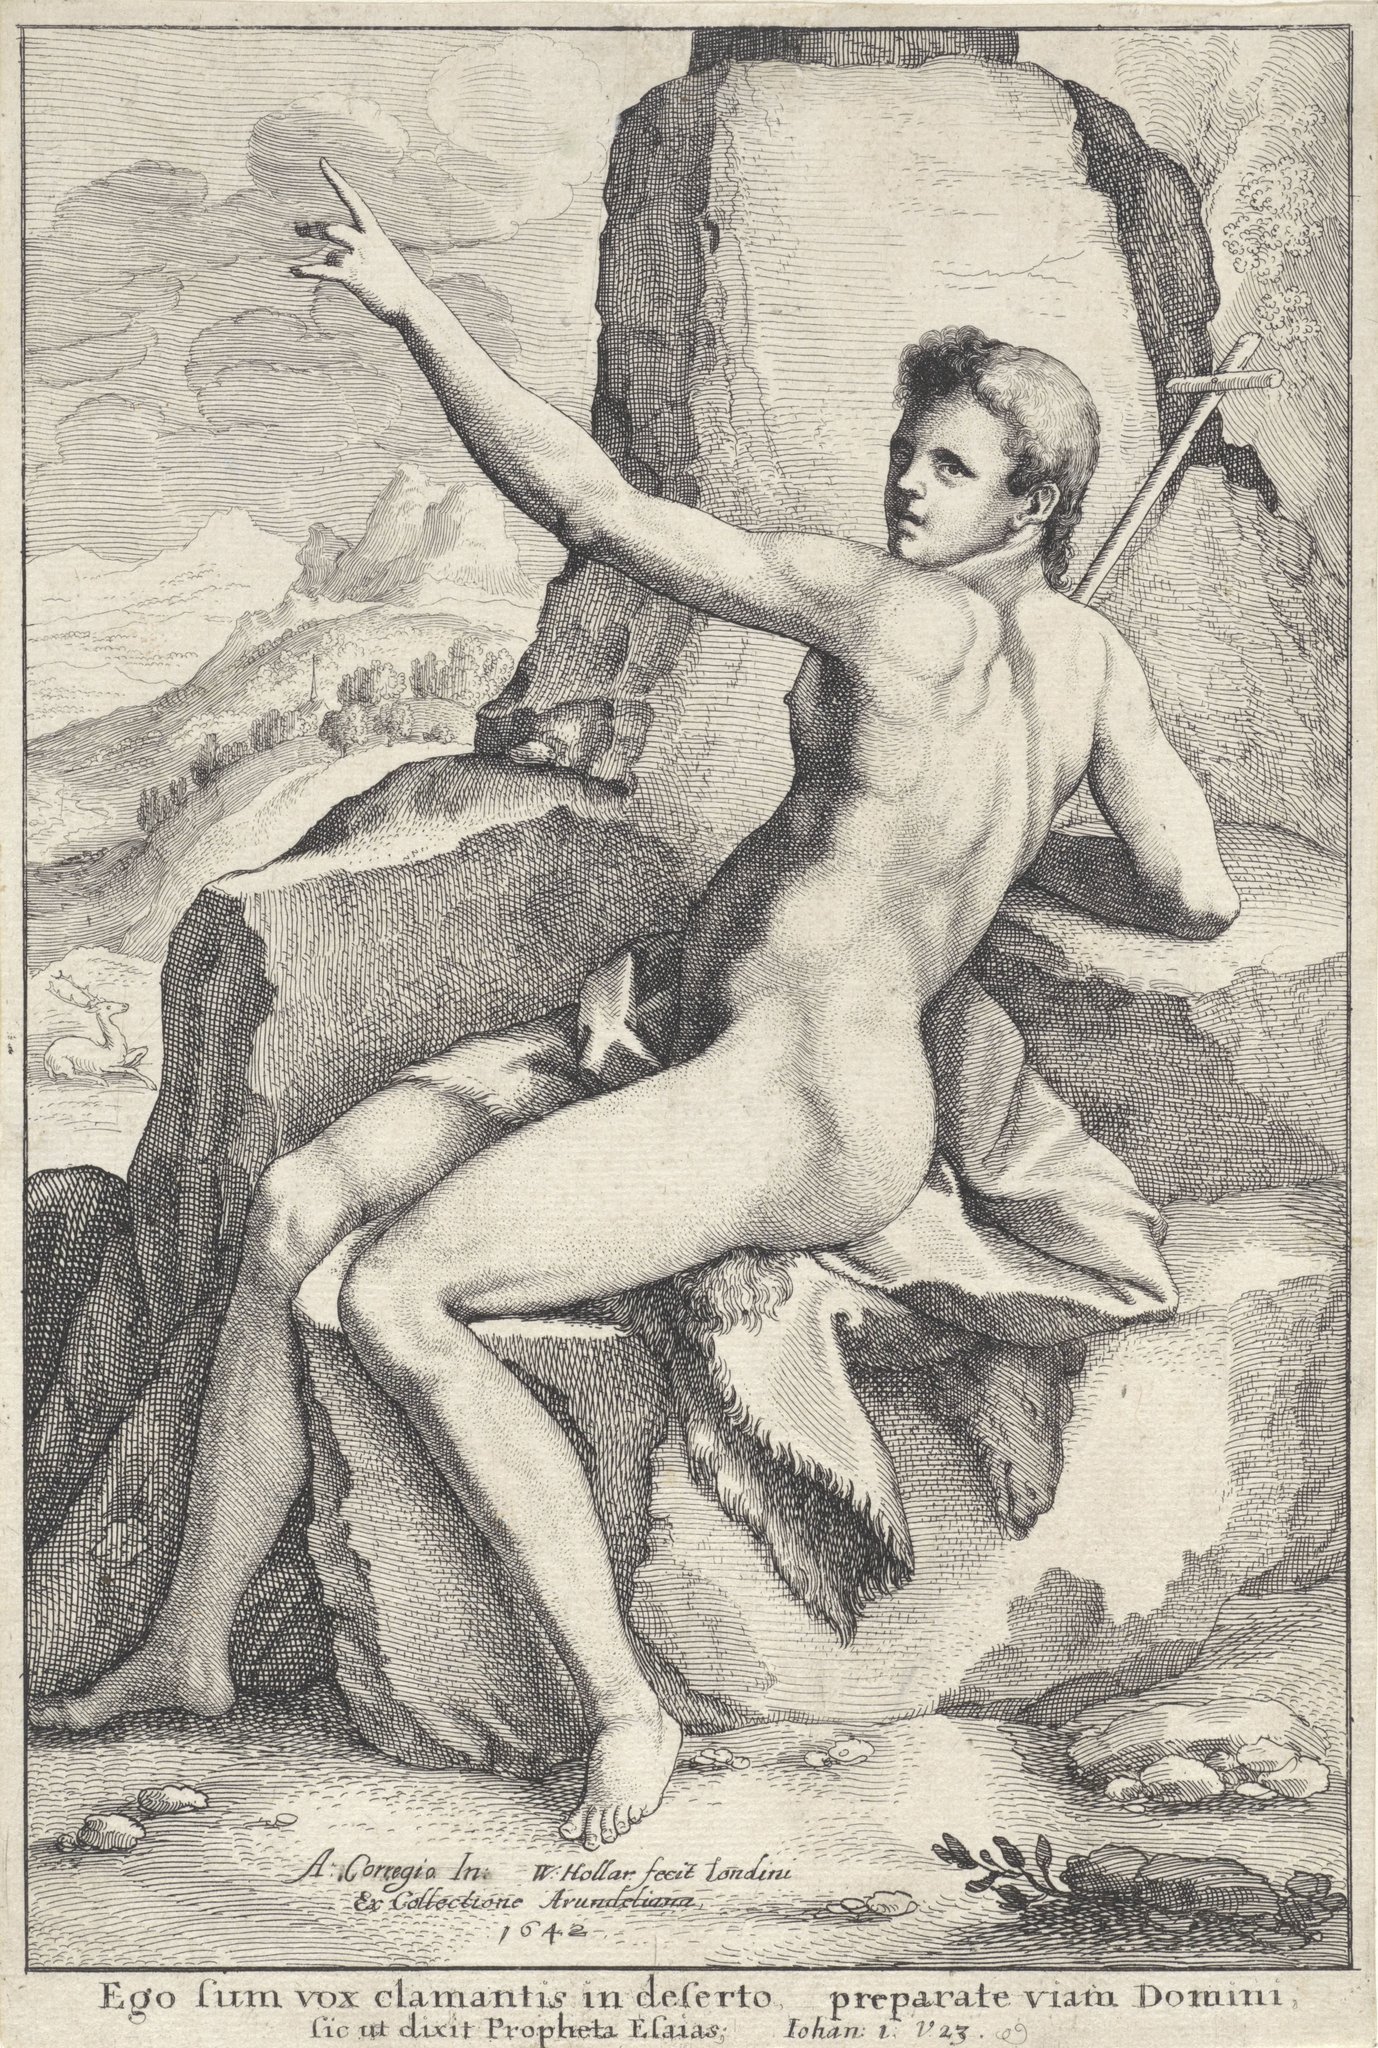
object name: print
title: Johannes de Doper in de woestijn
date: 1642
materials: paper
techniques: etching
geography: london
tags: john the baptist in the wilderness, usually accompanied by a lamb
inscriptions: collector's mark: Lugt 2228, collector's mark: Lugt 2773